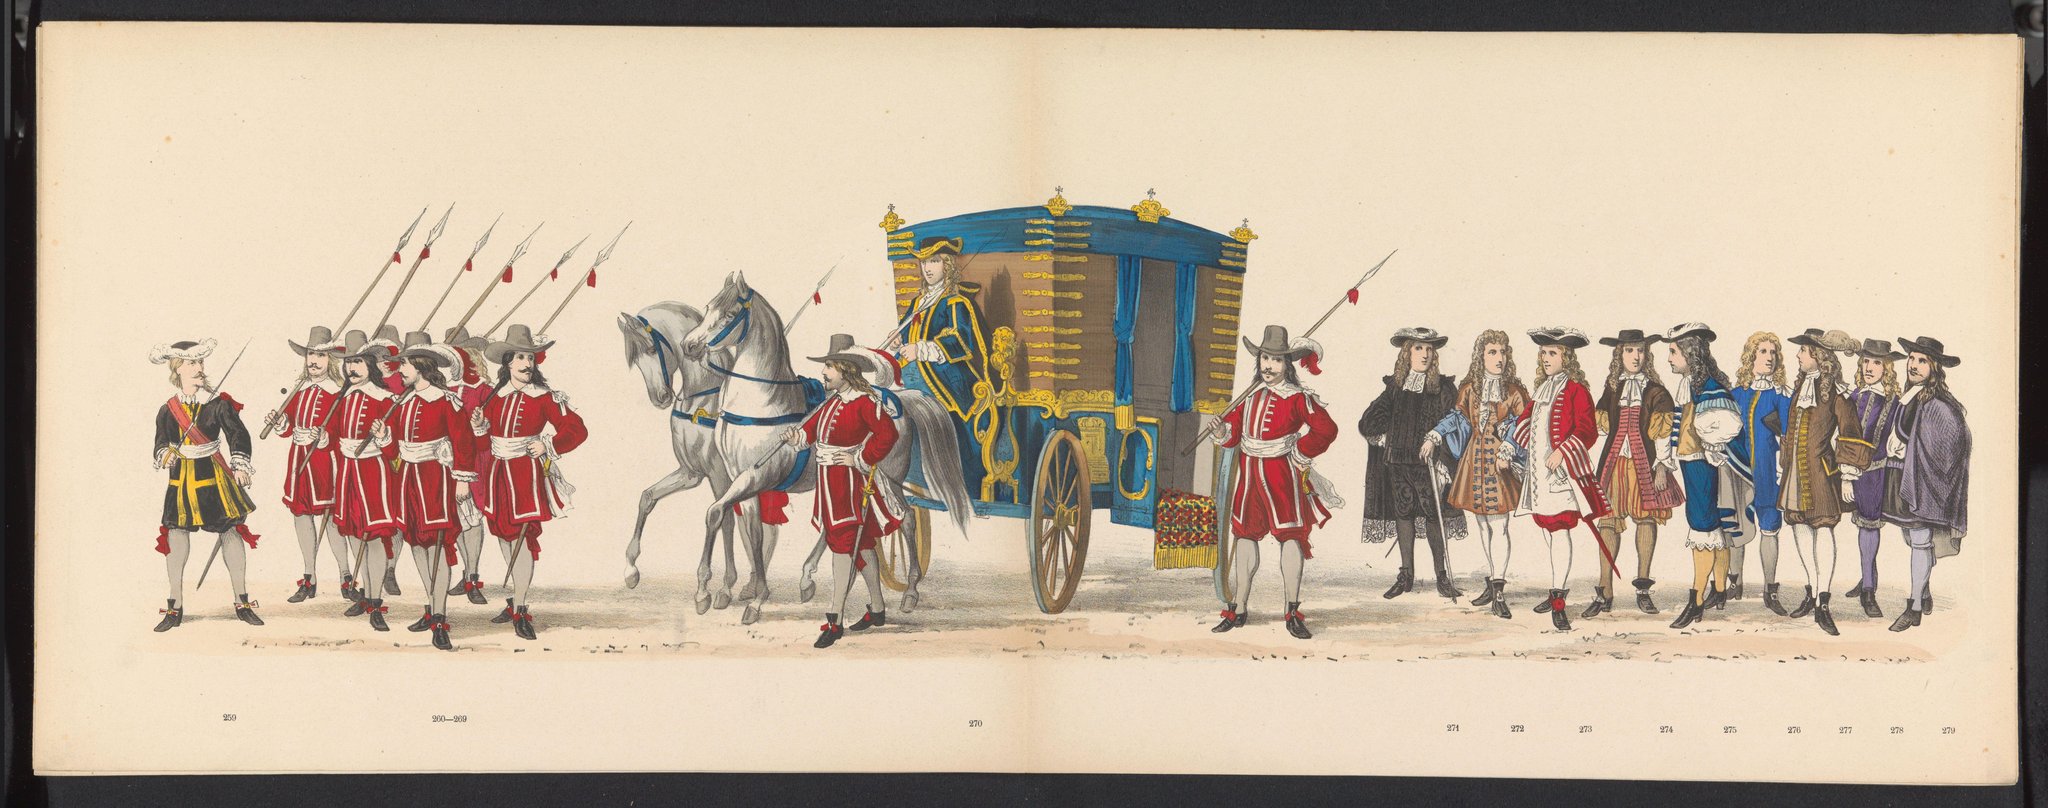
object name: print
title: Maskerade gehouden door de leden van het Leidsche studentencorps den 15den Juni 1875 ter viering van den 300sten verjaardag der Leidsche Hoogeschool, voorstellende de Leidsche Hoogeschool, afgebeeld in de beroemdste en merkwaardigste mannen, die van hare stichting af hun naam aan den haren hebben verbonden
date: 1875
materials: paper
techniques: hand coloring, lithograph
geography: leiden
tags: students' pageant, costumes used in pageants, leiden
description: Historische gekostumeerde optocht van de studenten van de Leidse Hogeschool gehouden op 15 juni 1875 ter gelegenheid van het 300-jarig bestaan van de Hogeschool. De optocht verbeeldt de beroemdste mannen verbonden aan de Hogeschool. Achttiende plaat met de groepen genummerd 259-279. Onderdeel van de serie van 21 aaneen geplakte bladen.